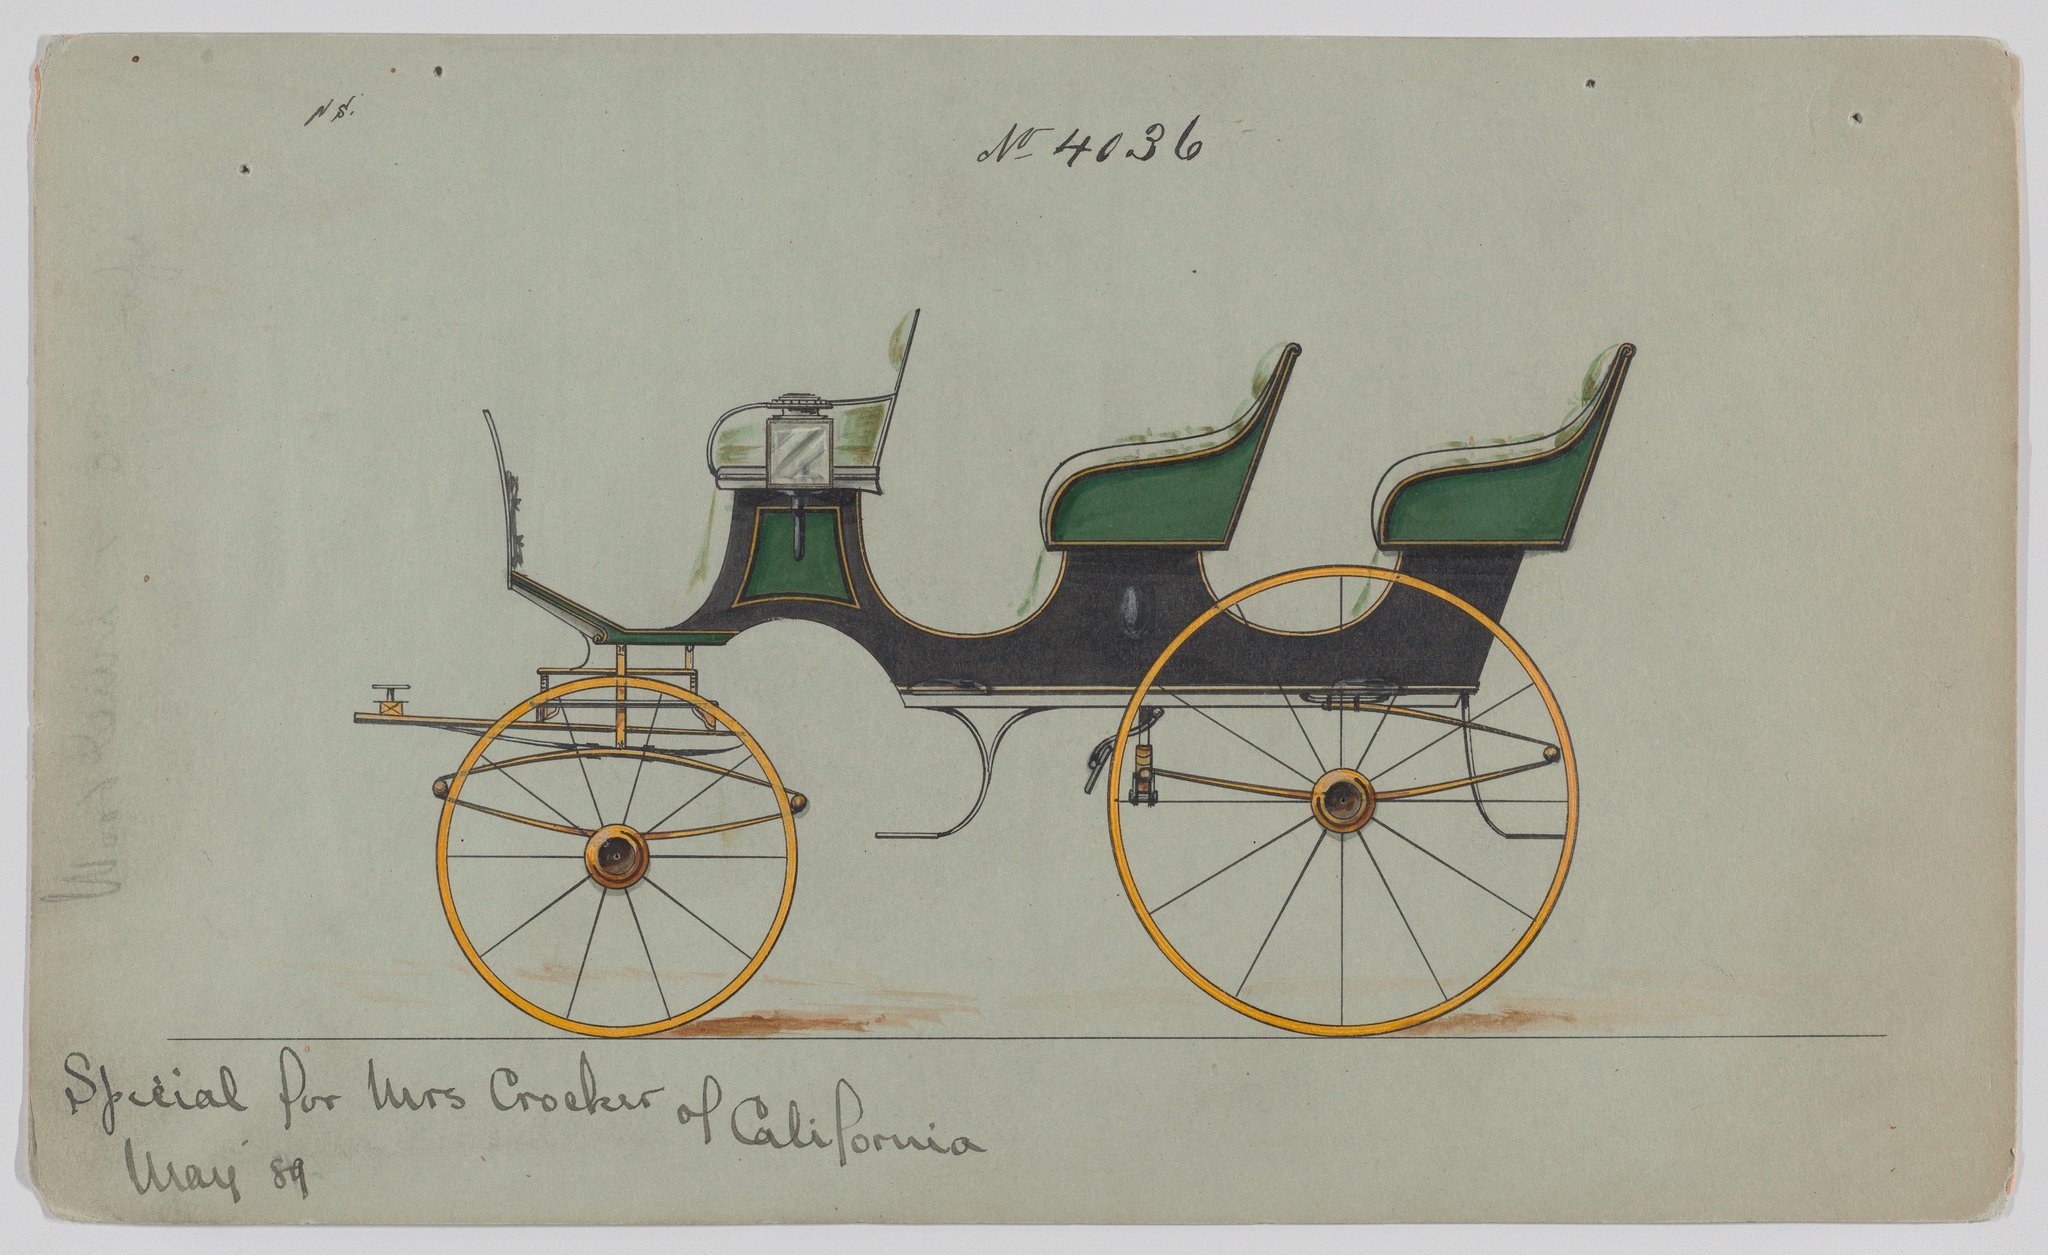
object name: drawing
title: Six Seat Phaeton #4036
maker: brewster & co.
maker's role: manufacturer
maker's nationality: american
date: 1889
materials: gouache, gum arabic, ink, watercolor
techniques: pen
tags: carriages